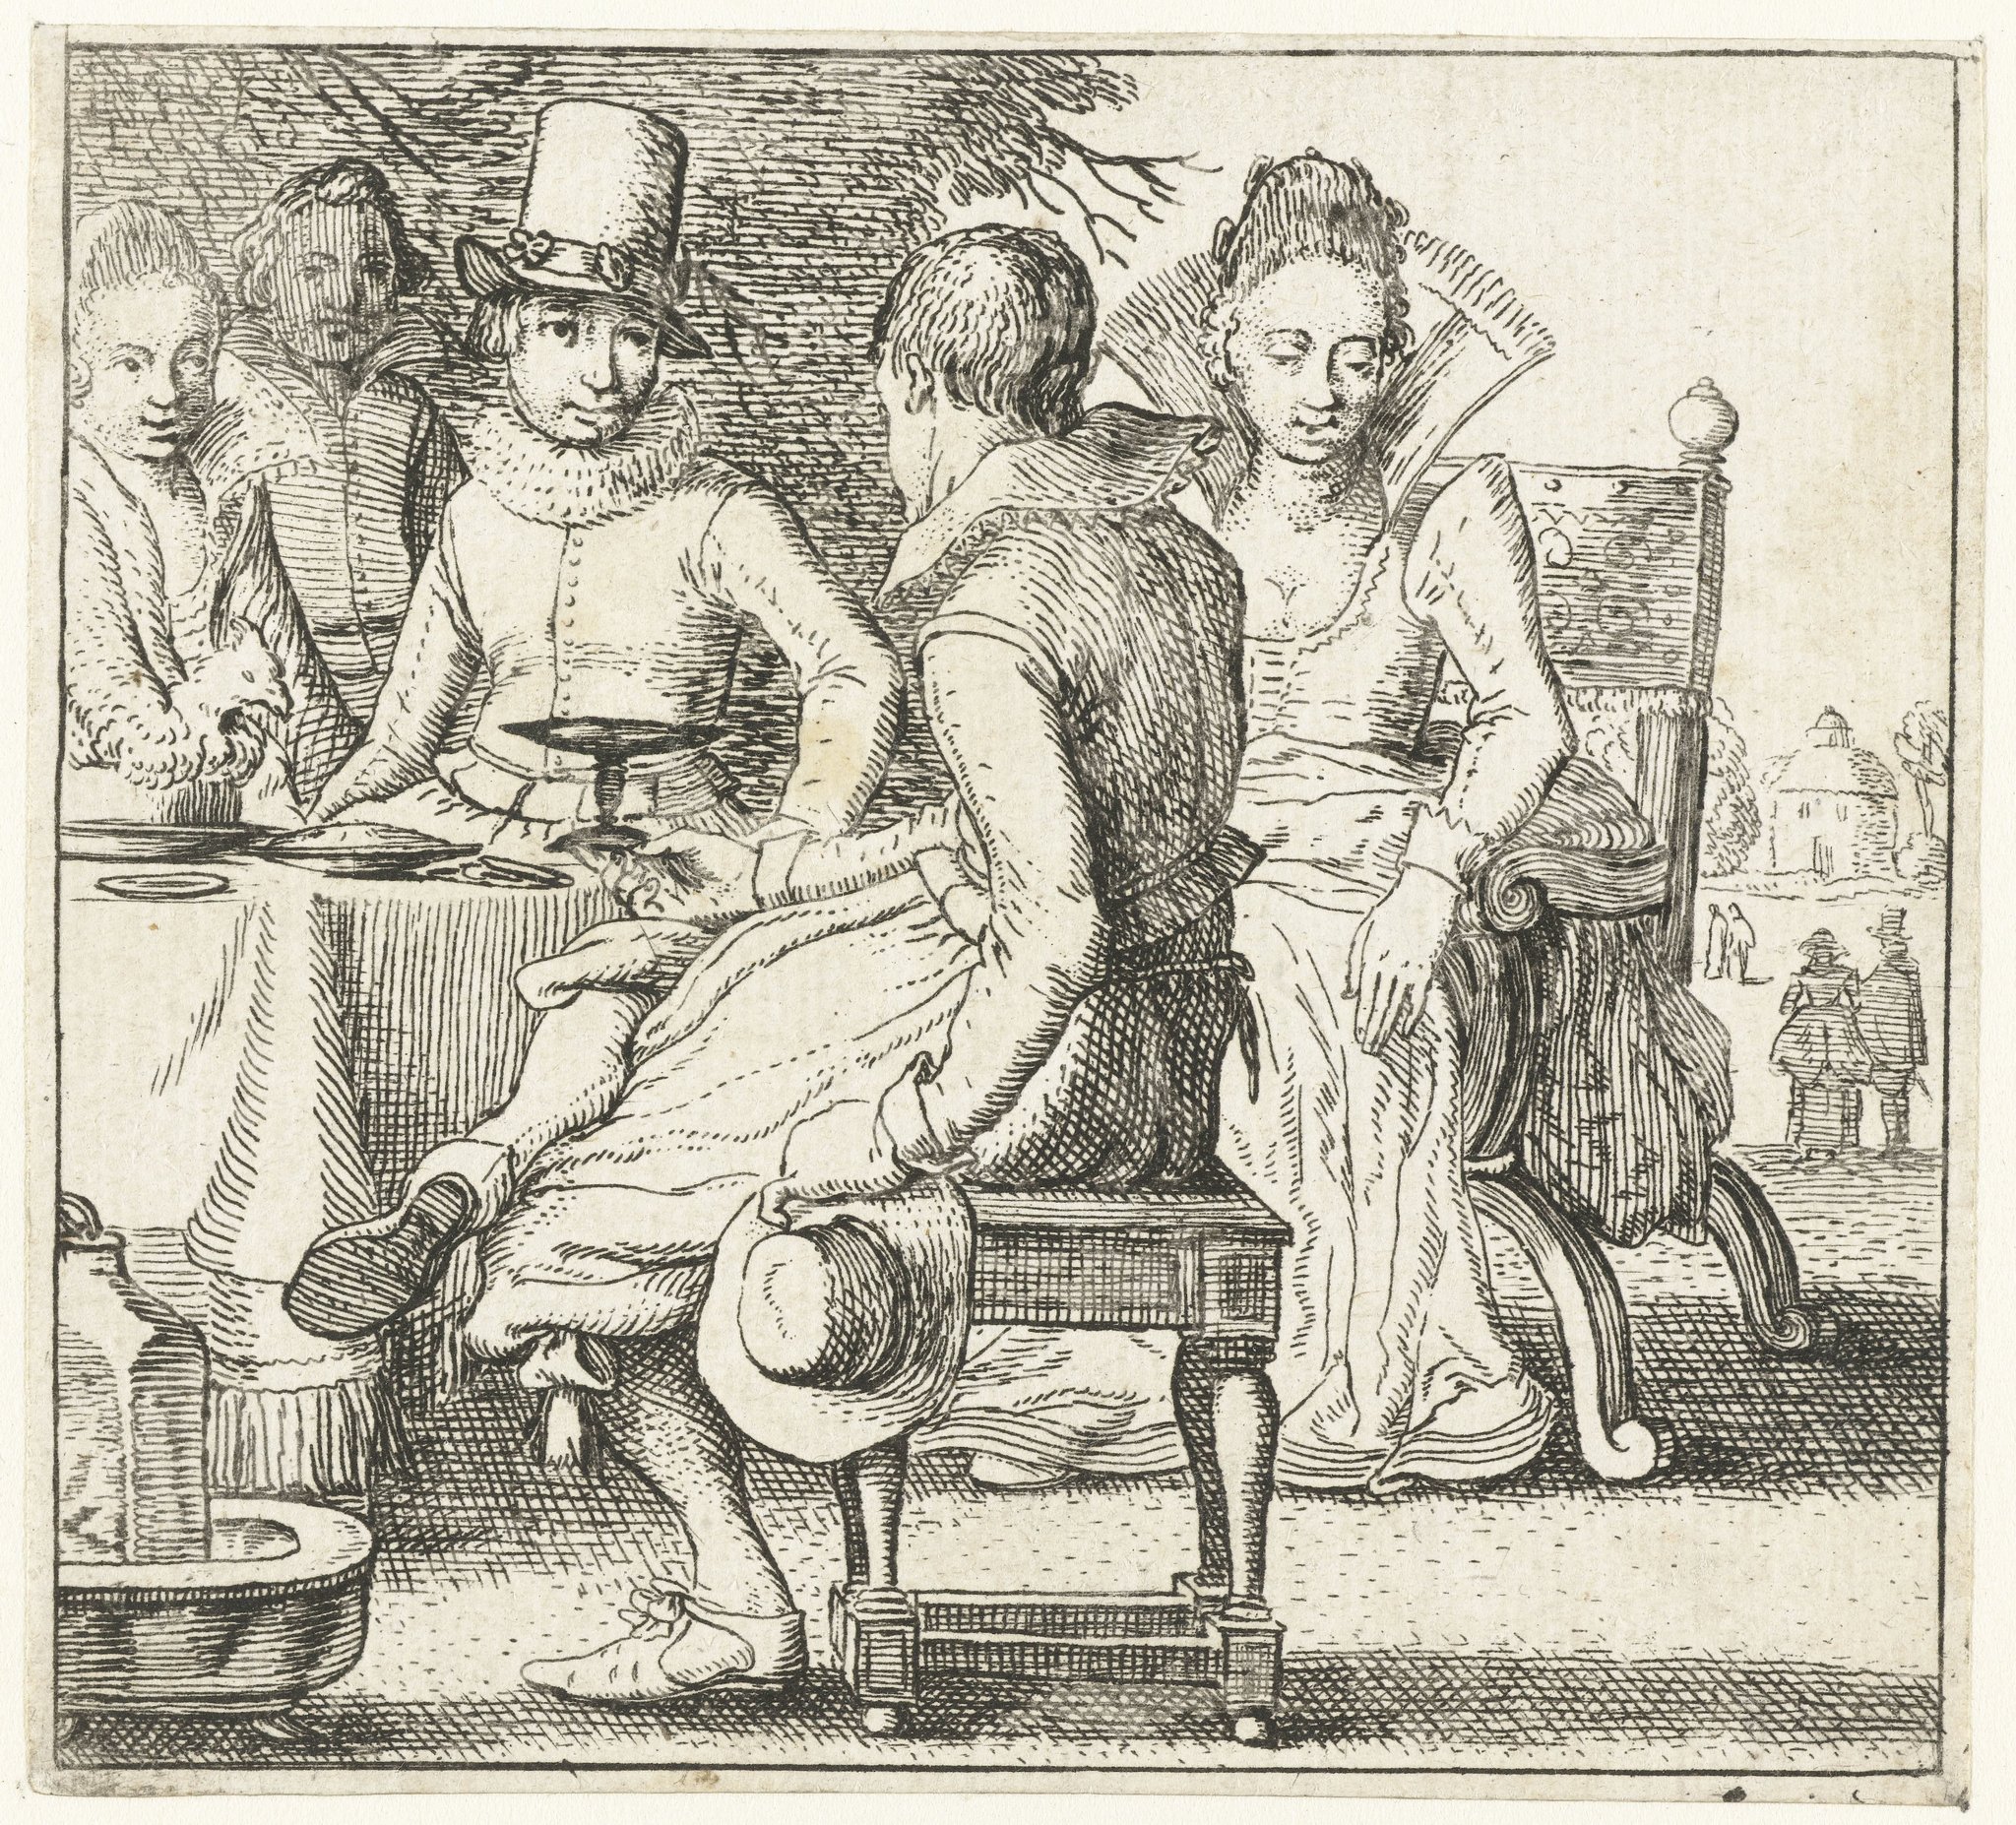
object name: print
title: Vijf personen zittend rond een tafel op een terras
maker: Anonymous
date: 1613-1680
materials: paper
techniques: etching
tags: visiting; receiving guests; elegant company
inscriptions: collector's mark: Lugt 2228a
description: Vijf modieus geklede dames en heren zitten en staan bij een gedekte tafel op een terras. Dit is een kopie in dezelfde richting als het origineel.